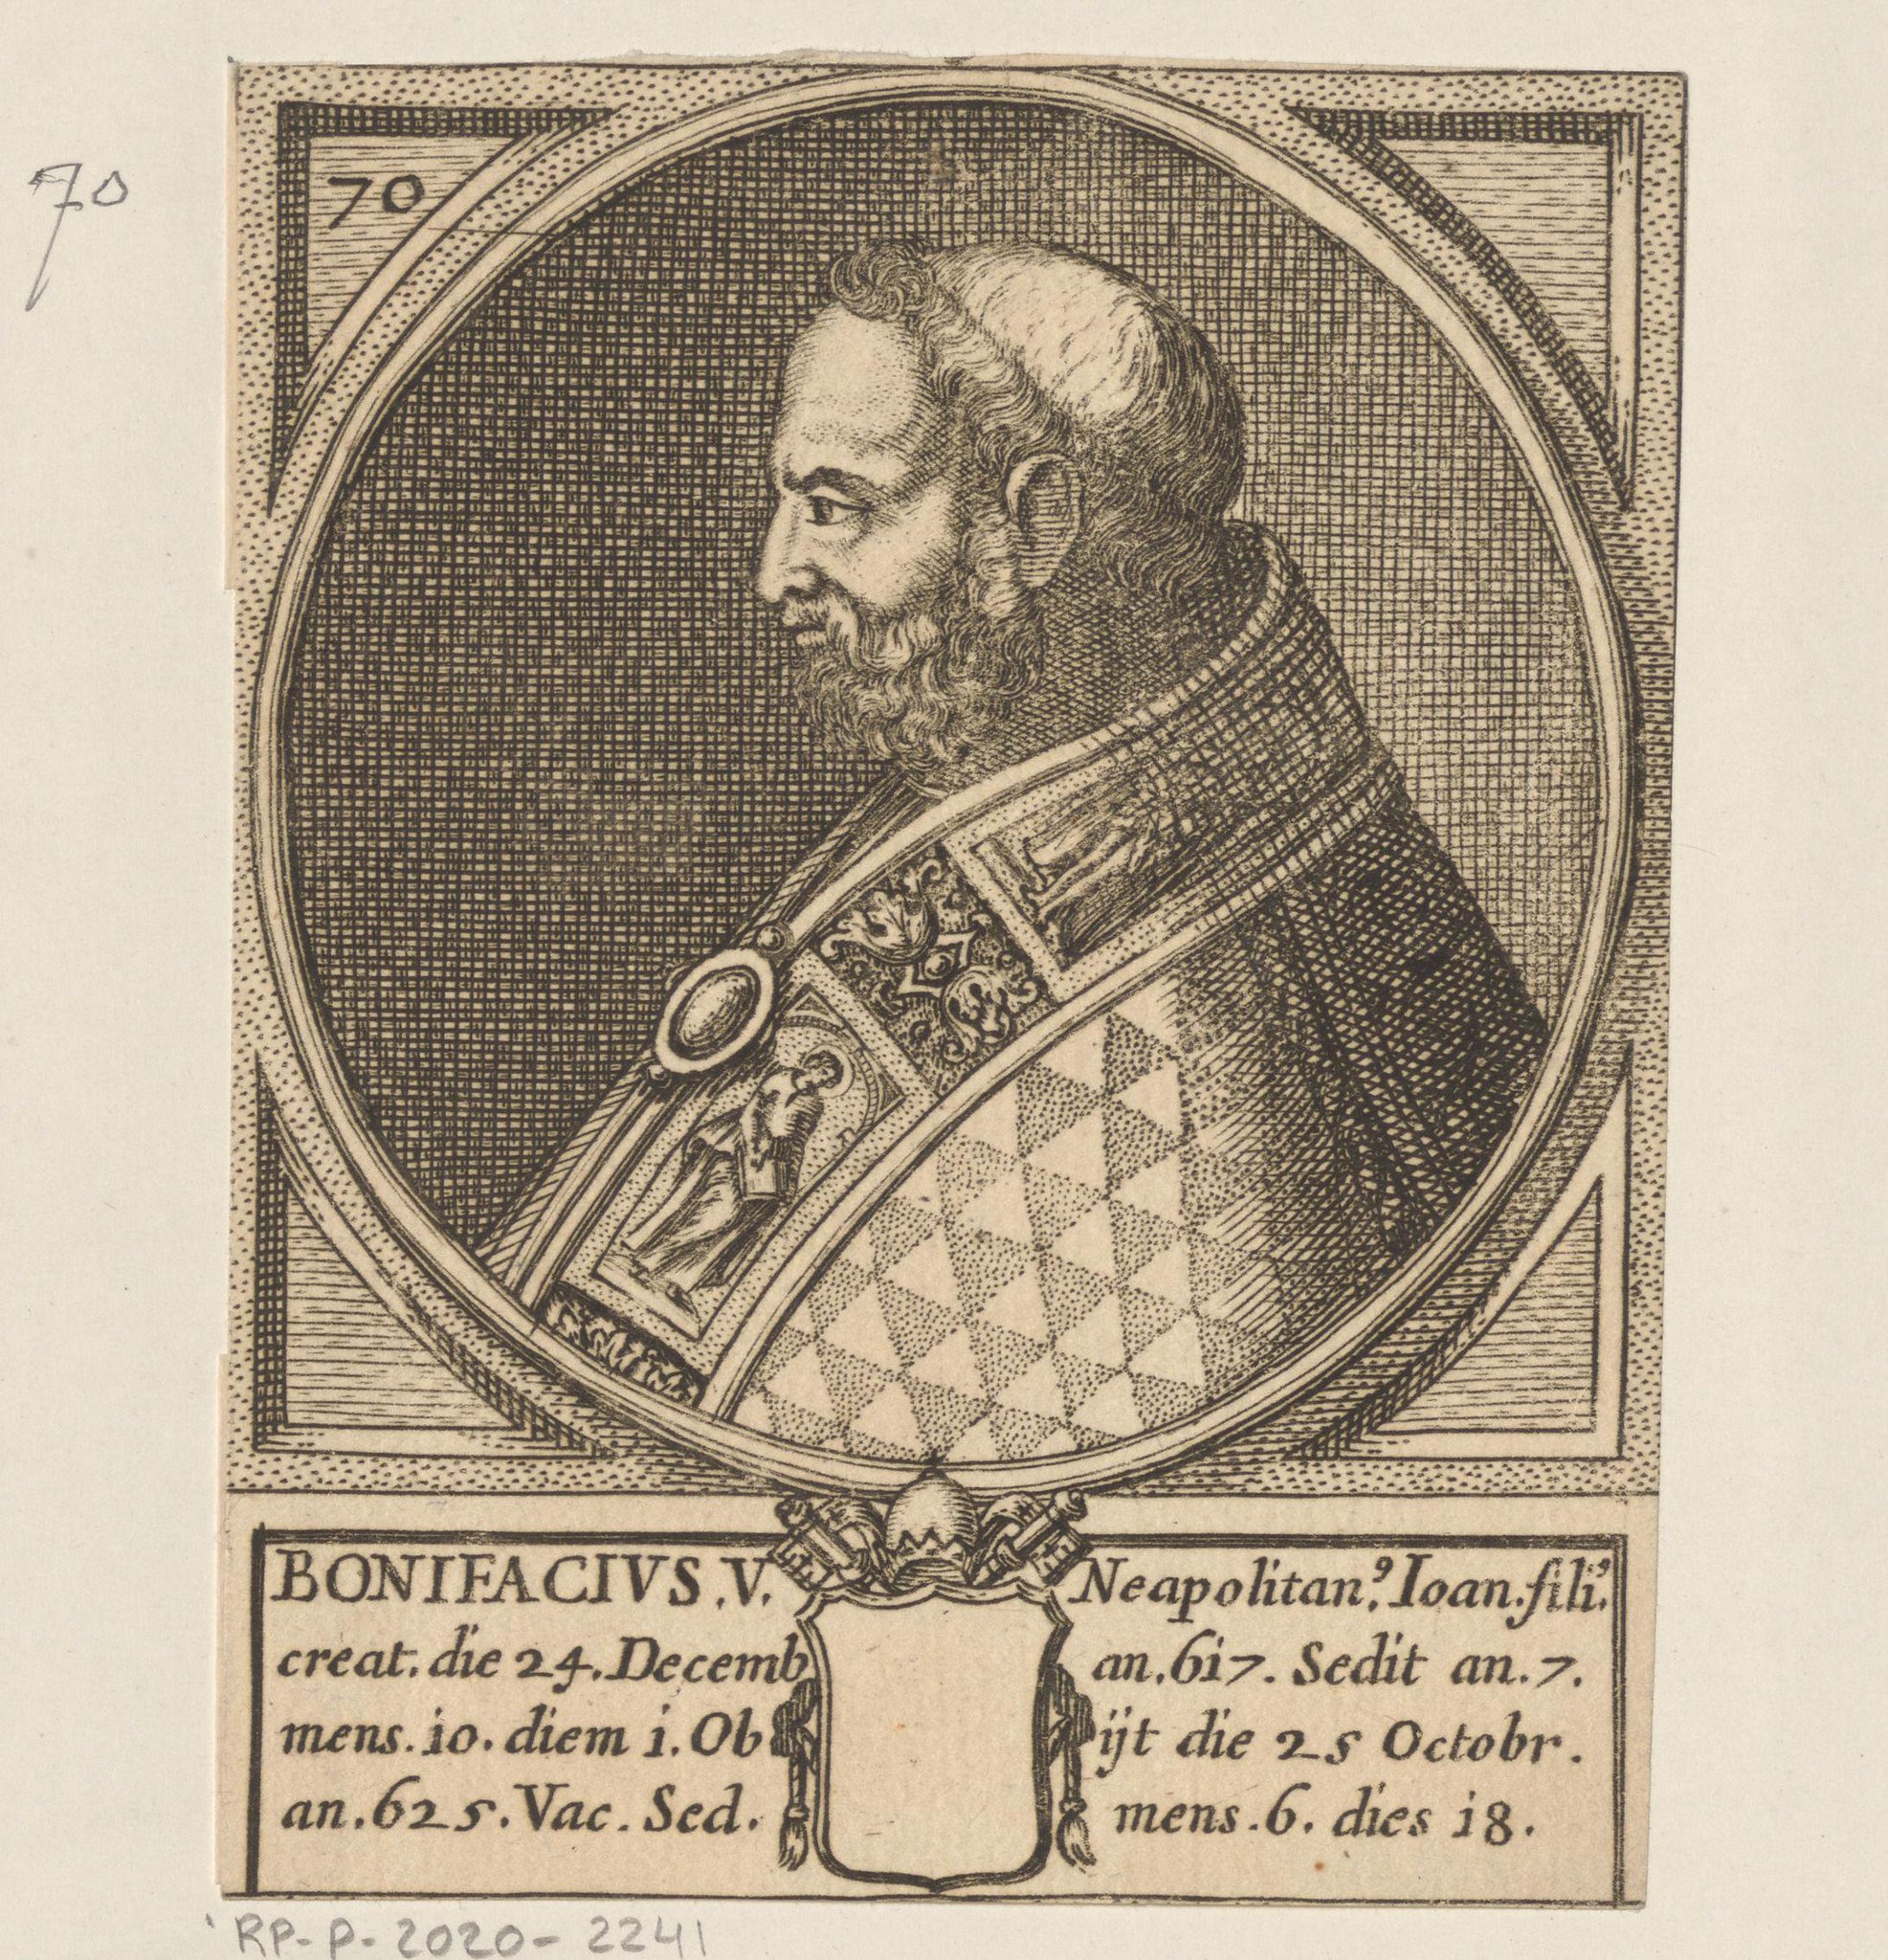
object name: print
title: Chronologische portretten van pausen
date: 1675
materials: paper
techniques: engraving, etching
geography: rome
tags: historical persons, pope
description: Portret afkomstig uit een grote prent, bestaande uit zeventien bladen die samengevoegd konden worden, uitgegeven door Giovanni Giacomo de' Rossi in 1675.